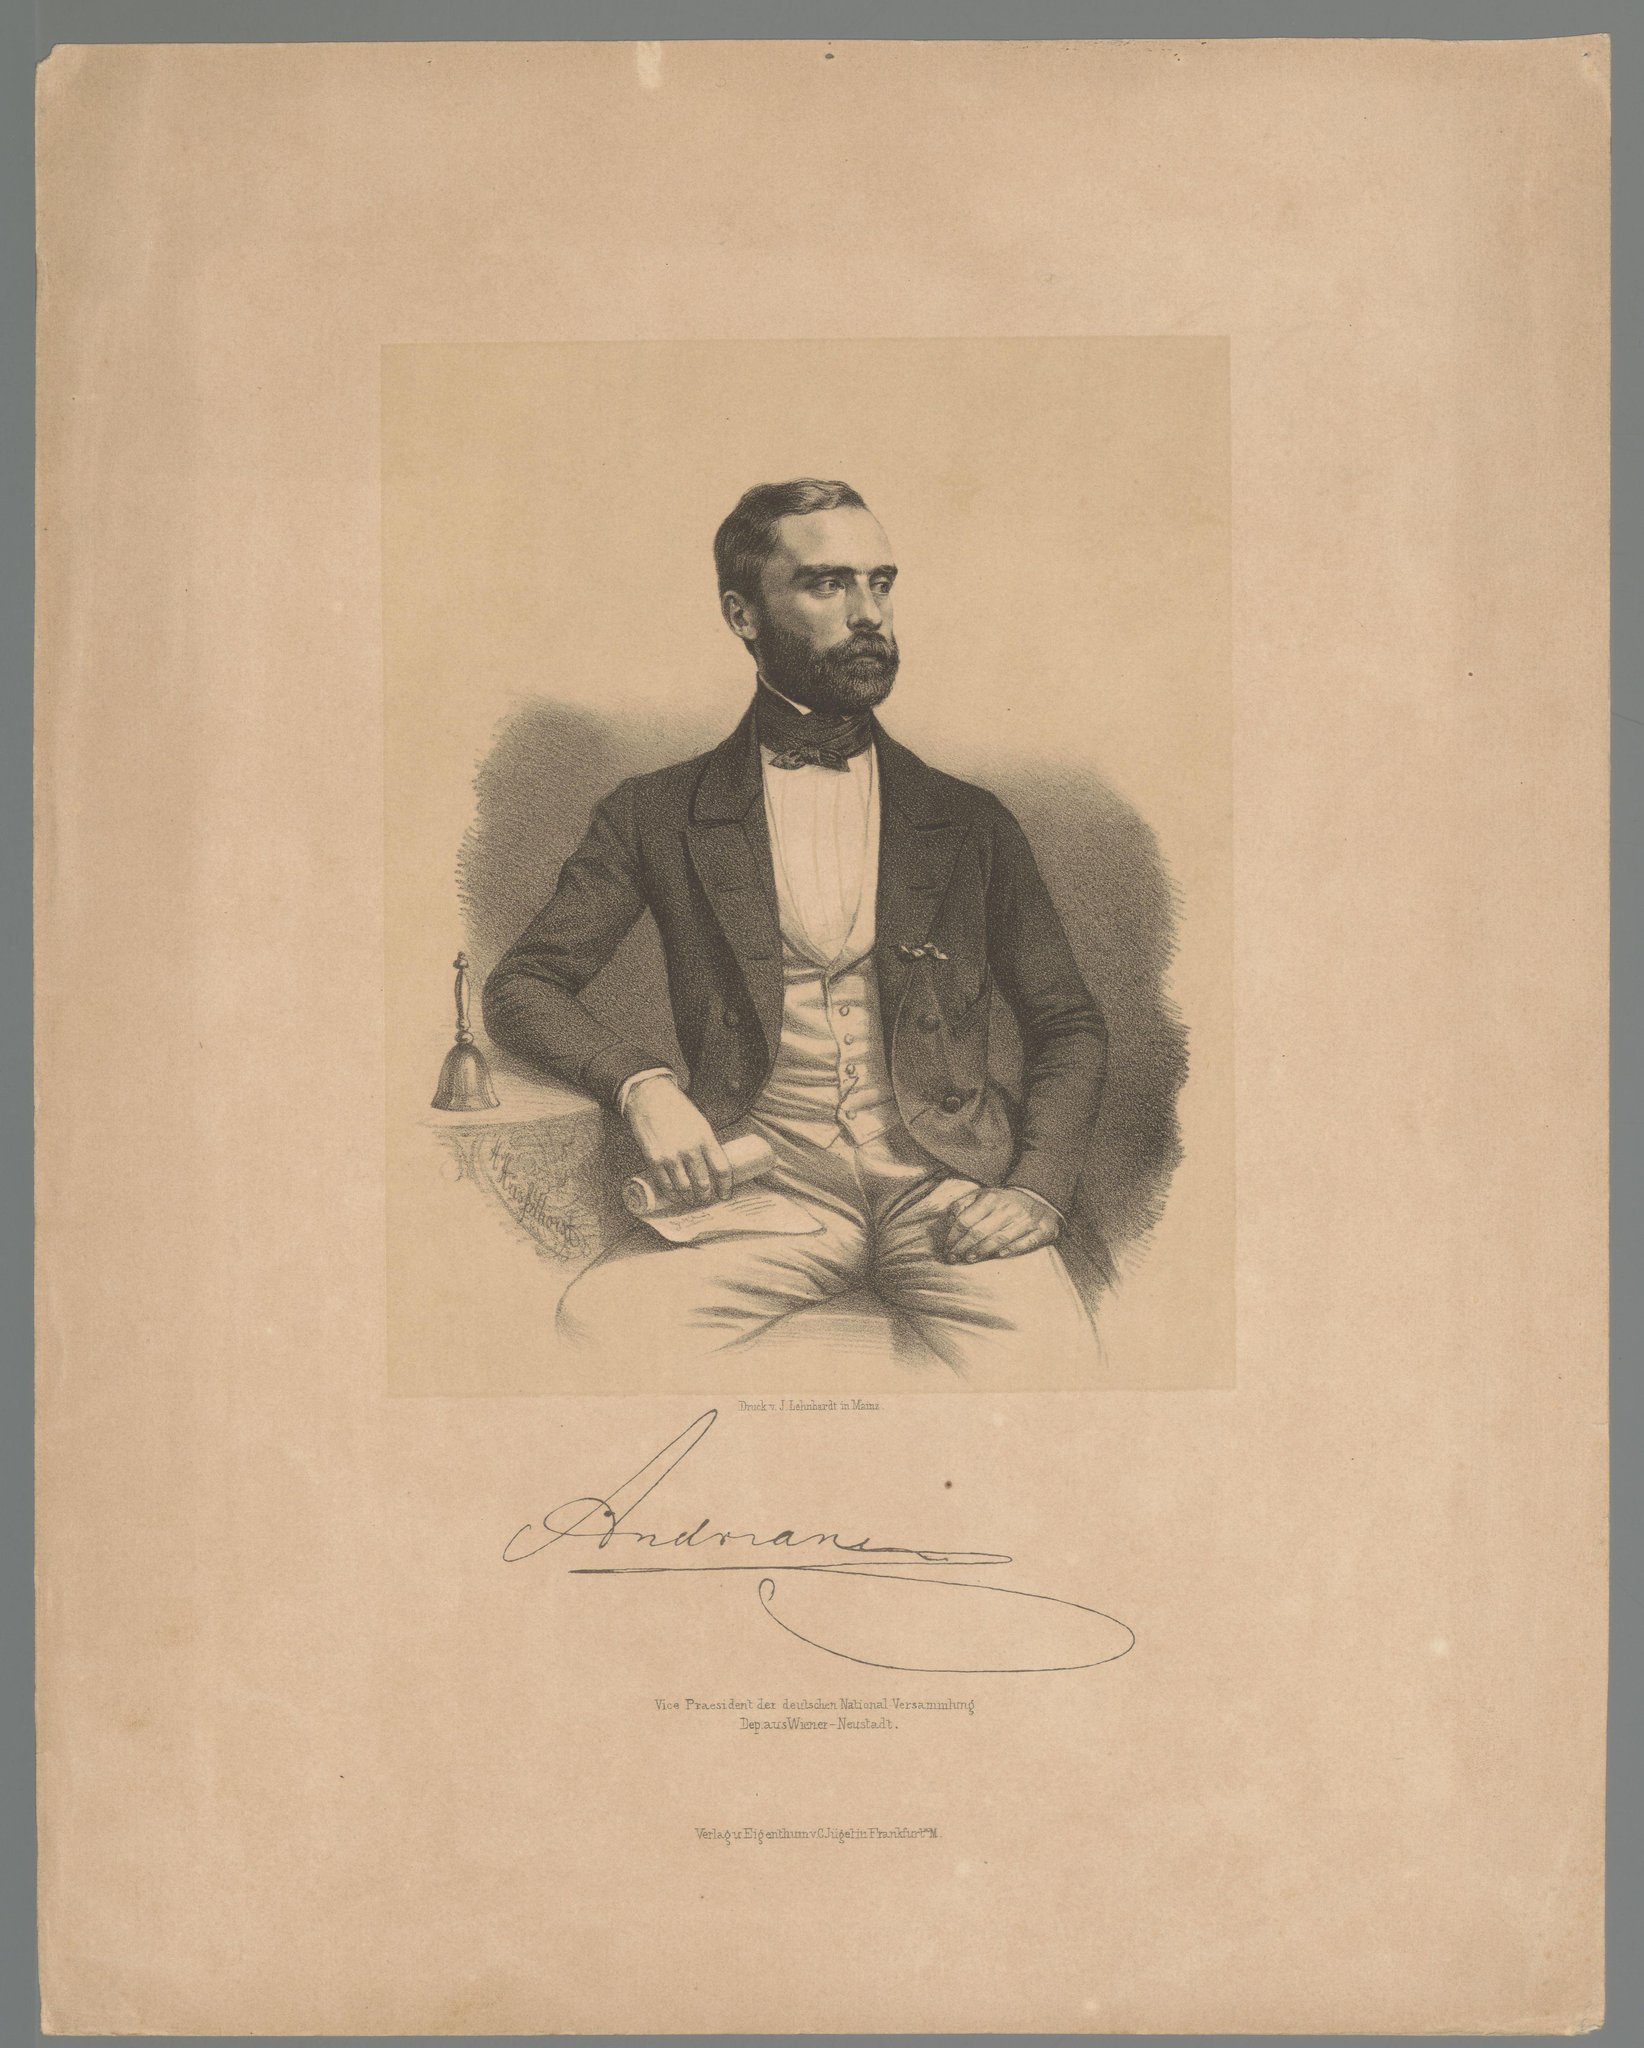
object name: print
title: Portret van een onbekende man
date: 1835-1862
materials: paper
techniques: lithograph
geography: mainz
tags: historical persons not known by name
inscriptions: collector's mark: Lugt 2228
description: Portret van een verder onbekende man, met handtekening in facsimile waarin de naam Andriani te lezen is.